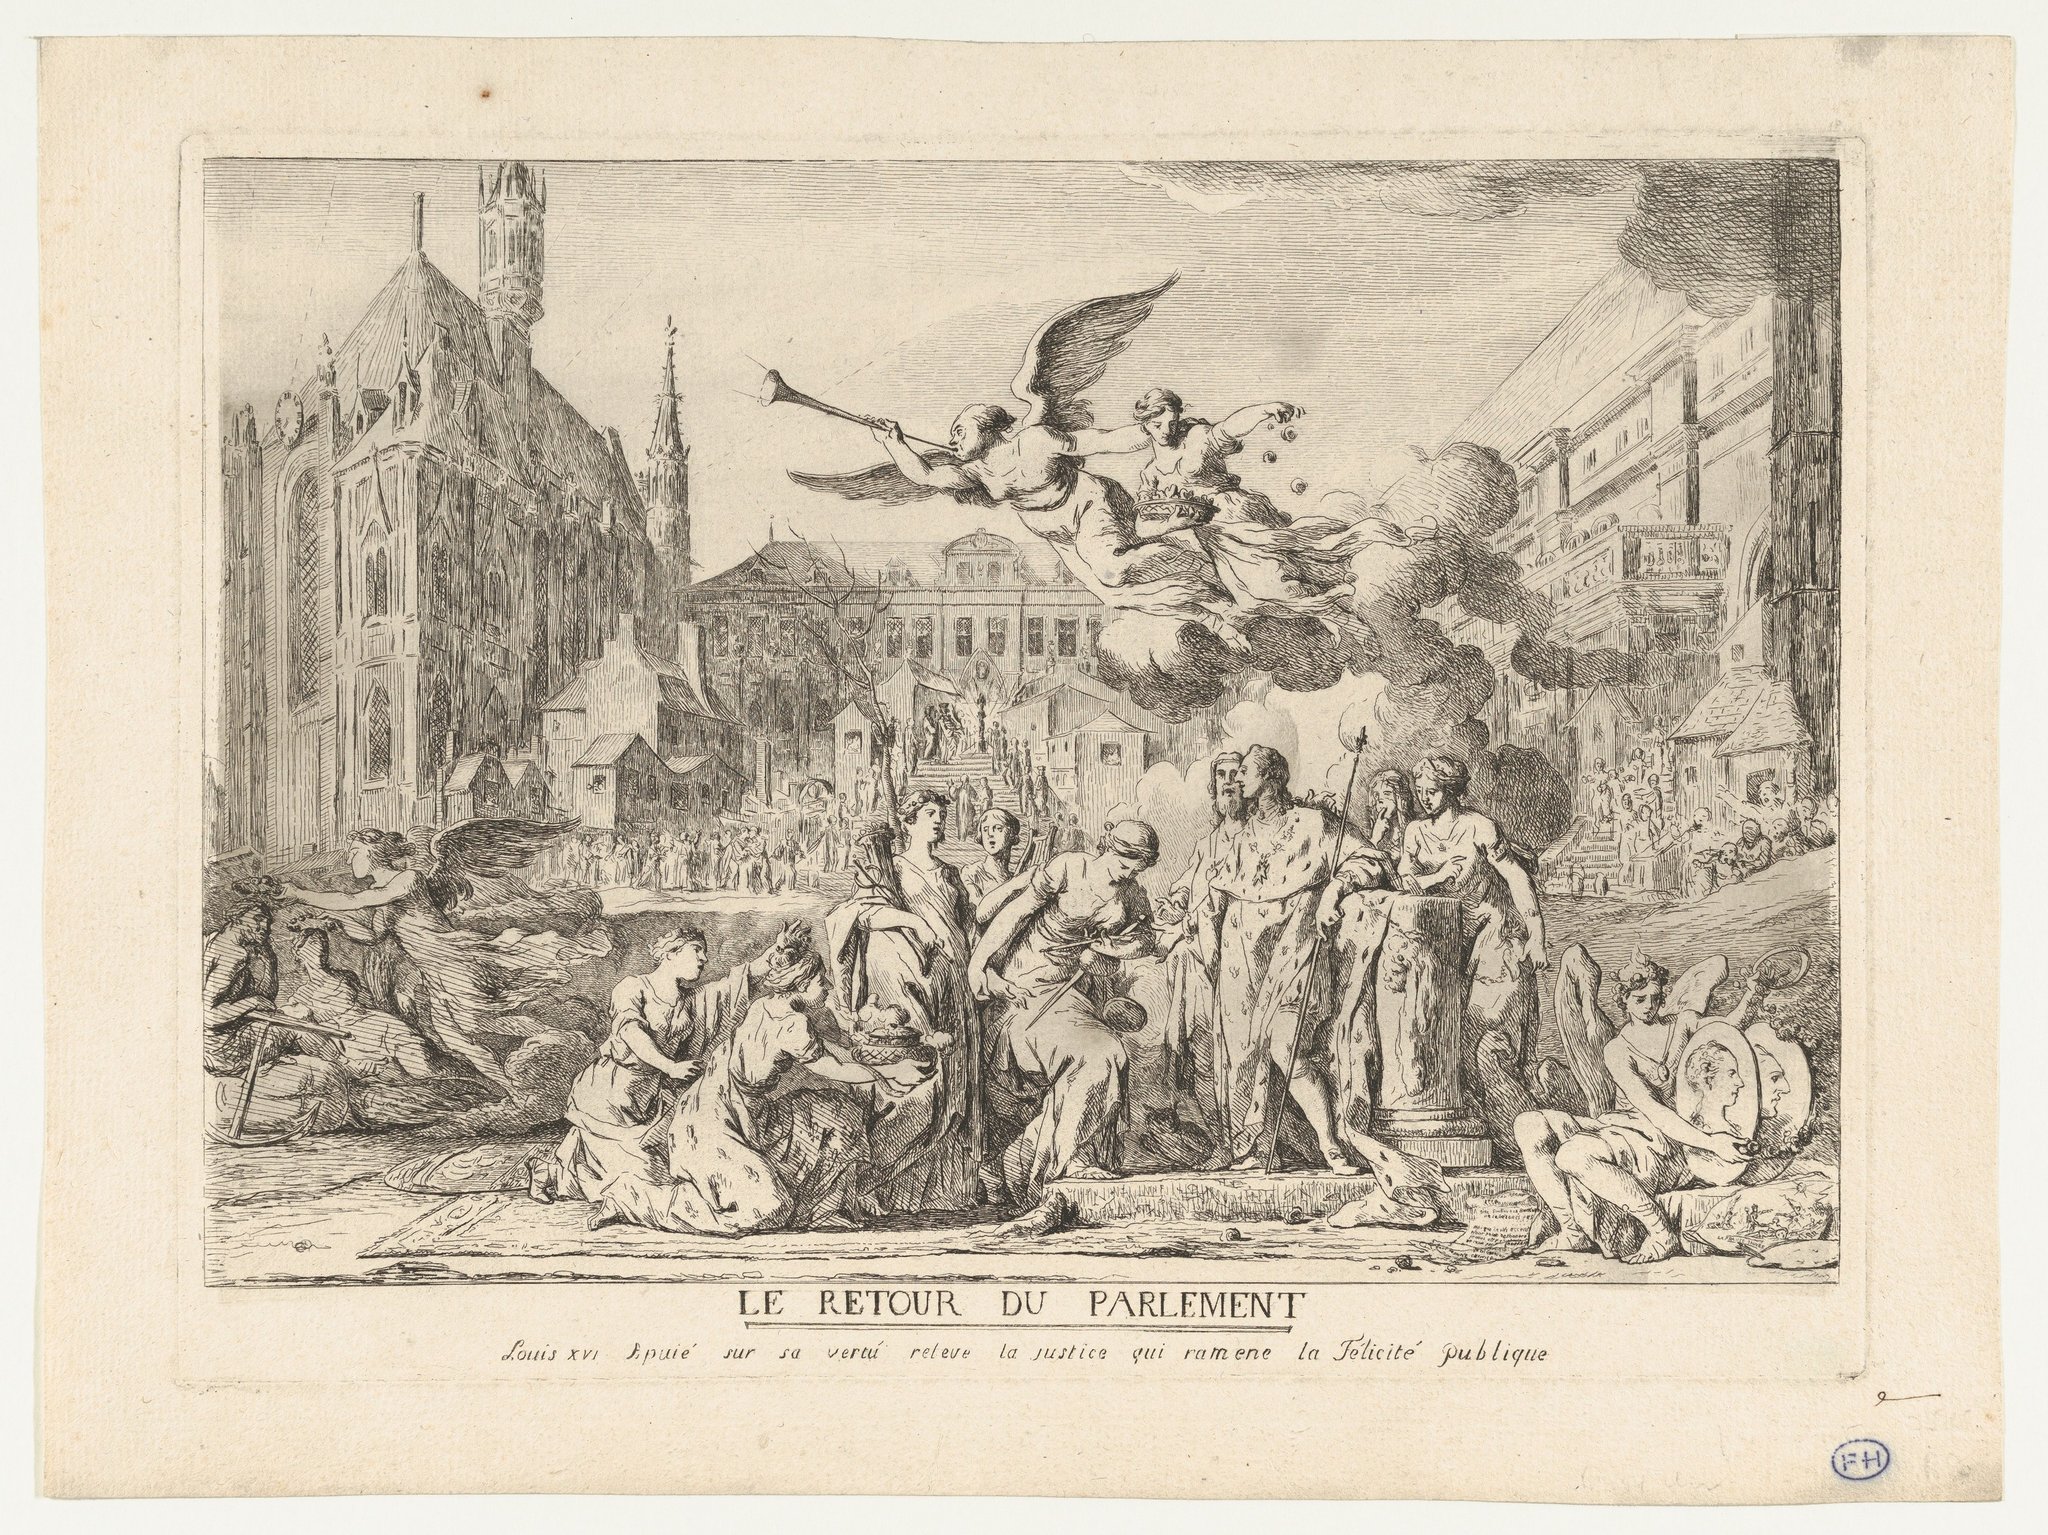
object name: print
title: The Return of the Parliament (Le Retour du Parlement)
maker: jean bernard restout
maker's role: artist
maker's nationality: french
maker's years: 1732-1797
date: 1774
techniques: etching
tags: men,women,angels